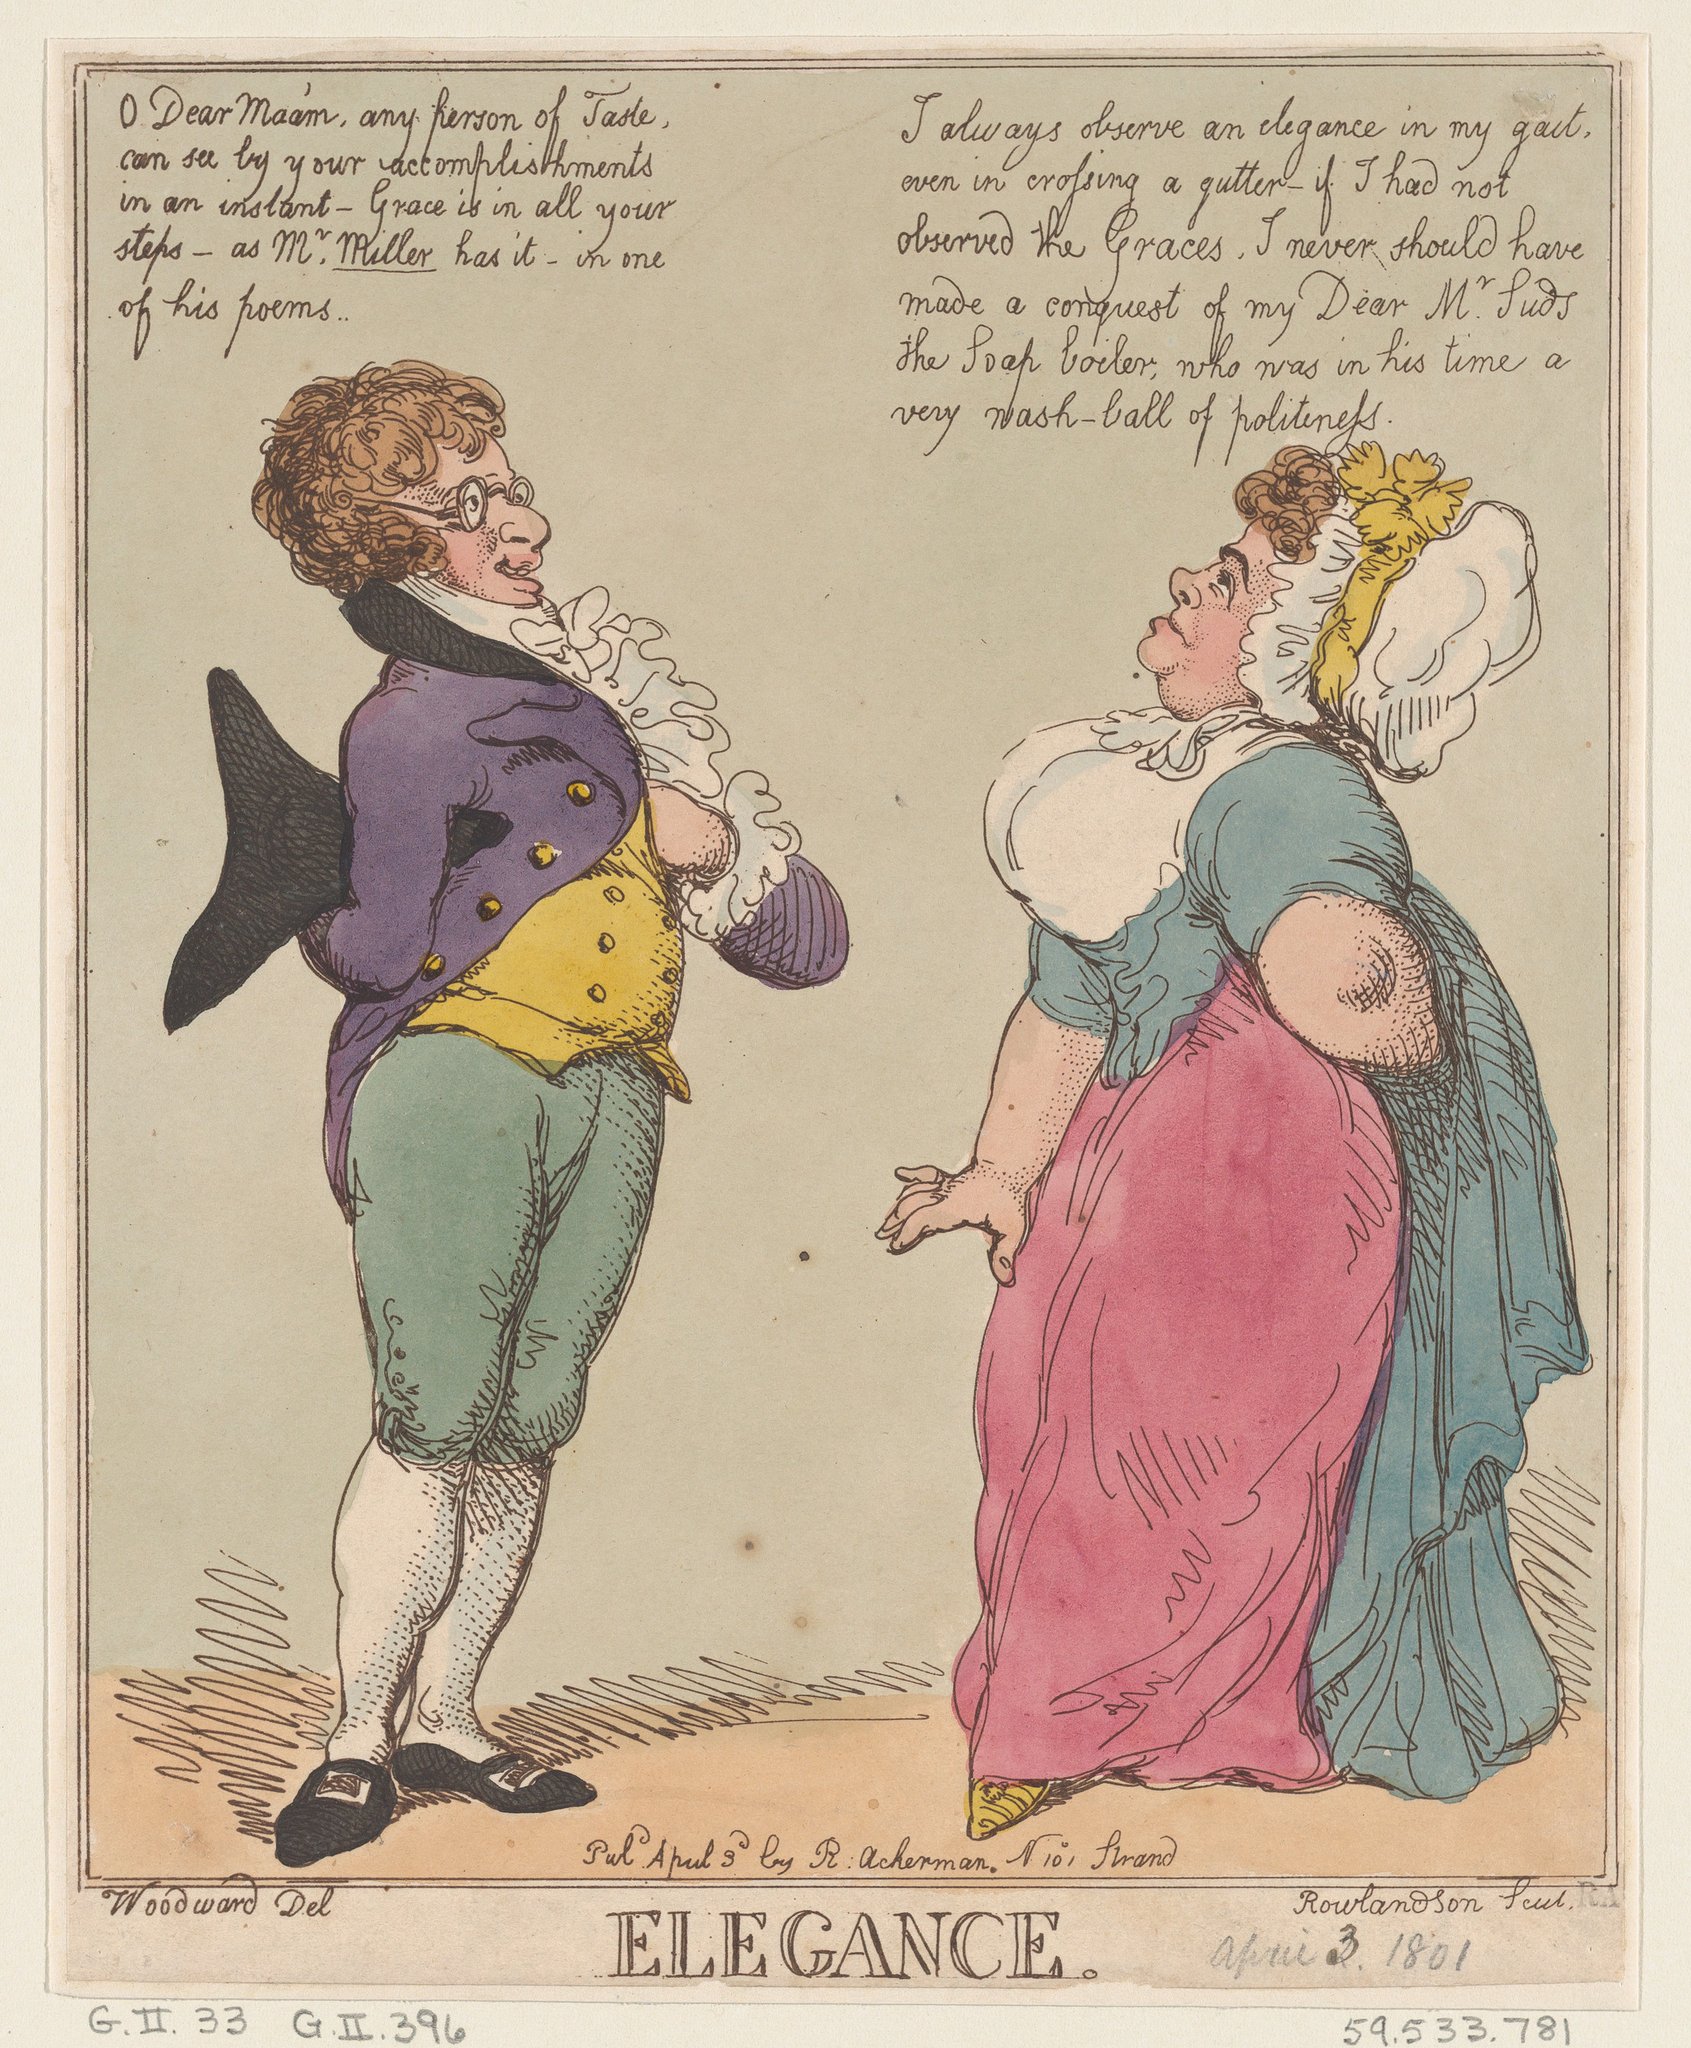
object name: print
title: Elegance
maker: thomas rowlandson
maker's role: artist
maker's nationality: british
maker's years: 1757-1827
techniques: etching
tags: men,women